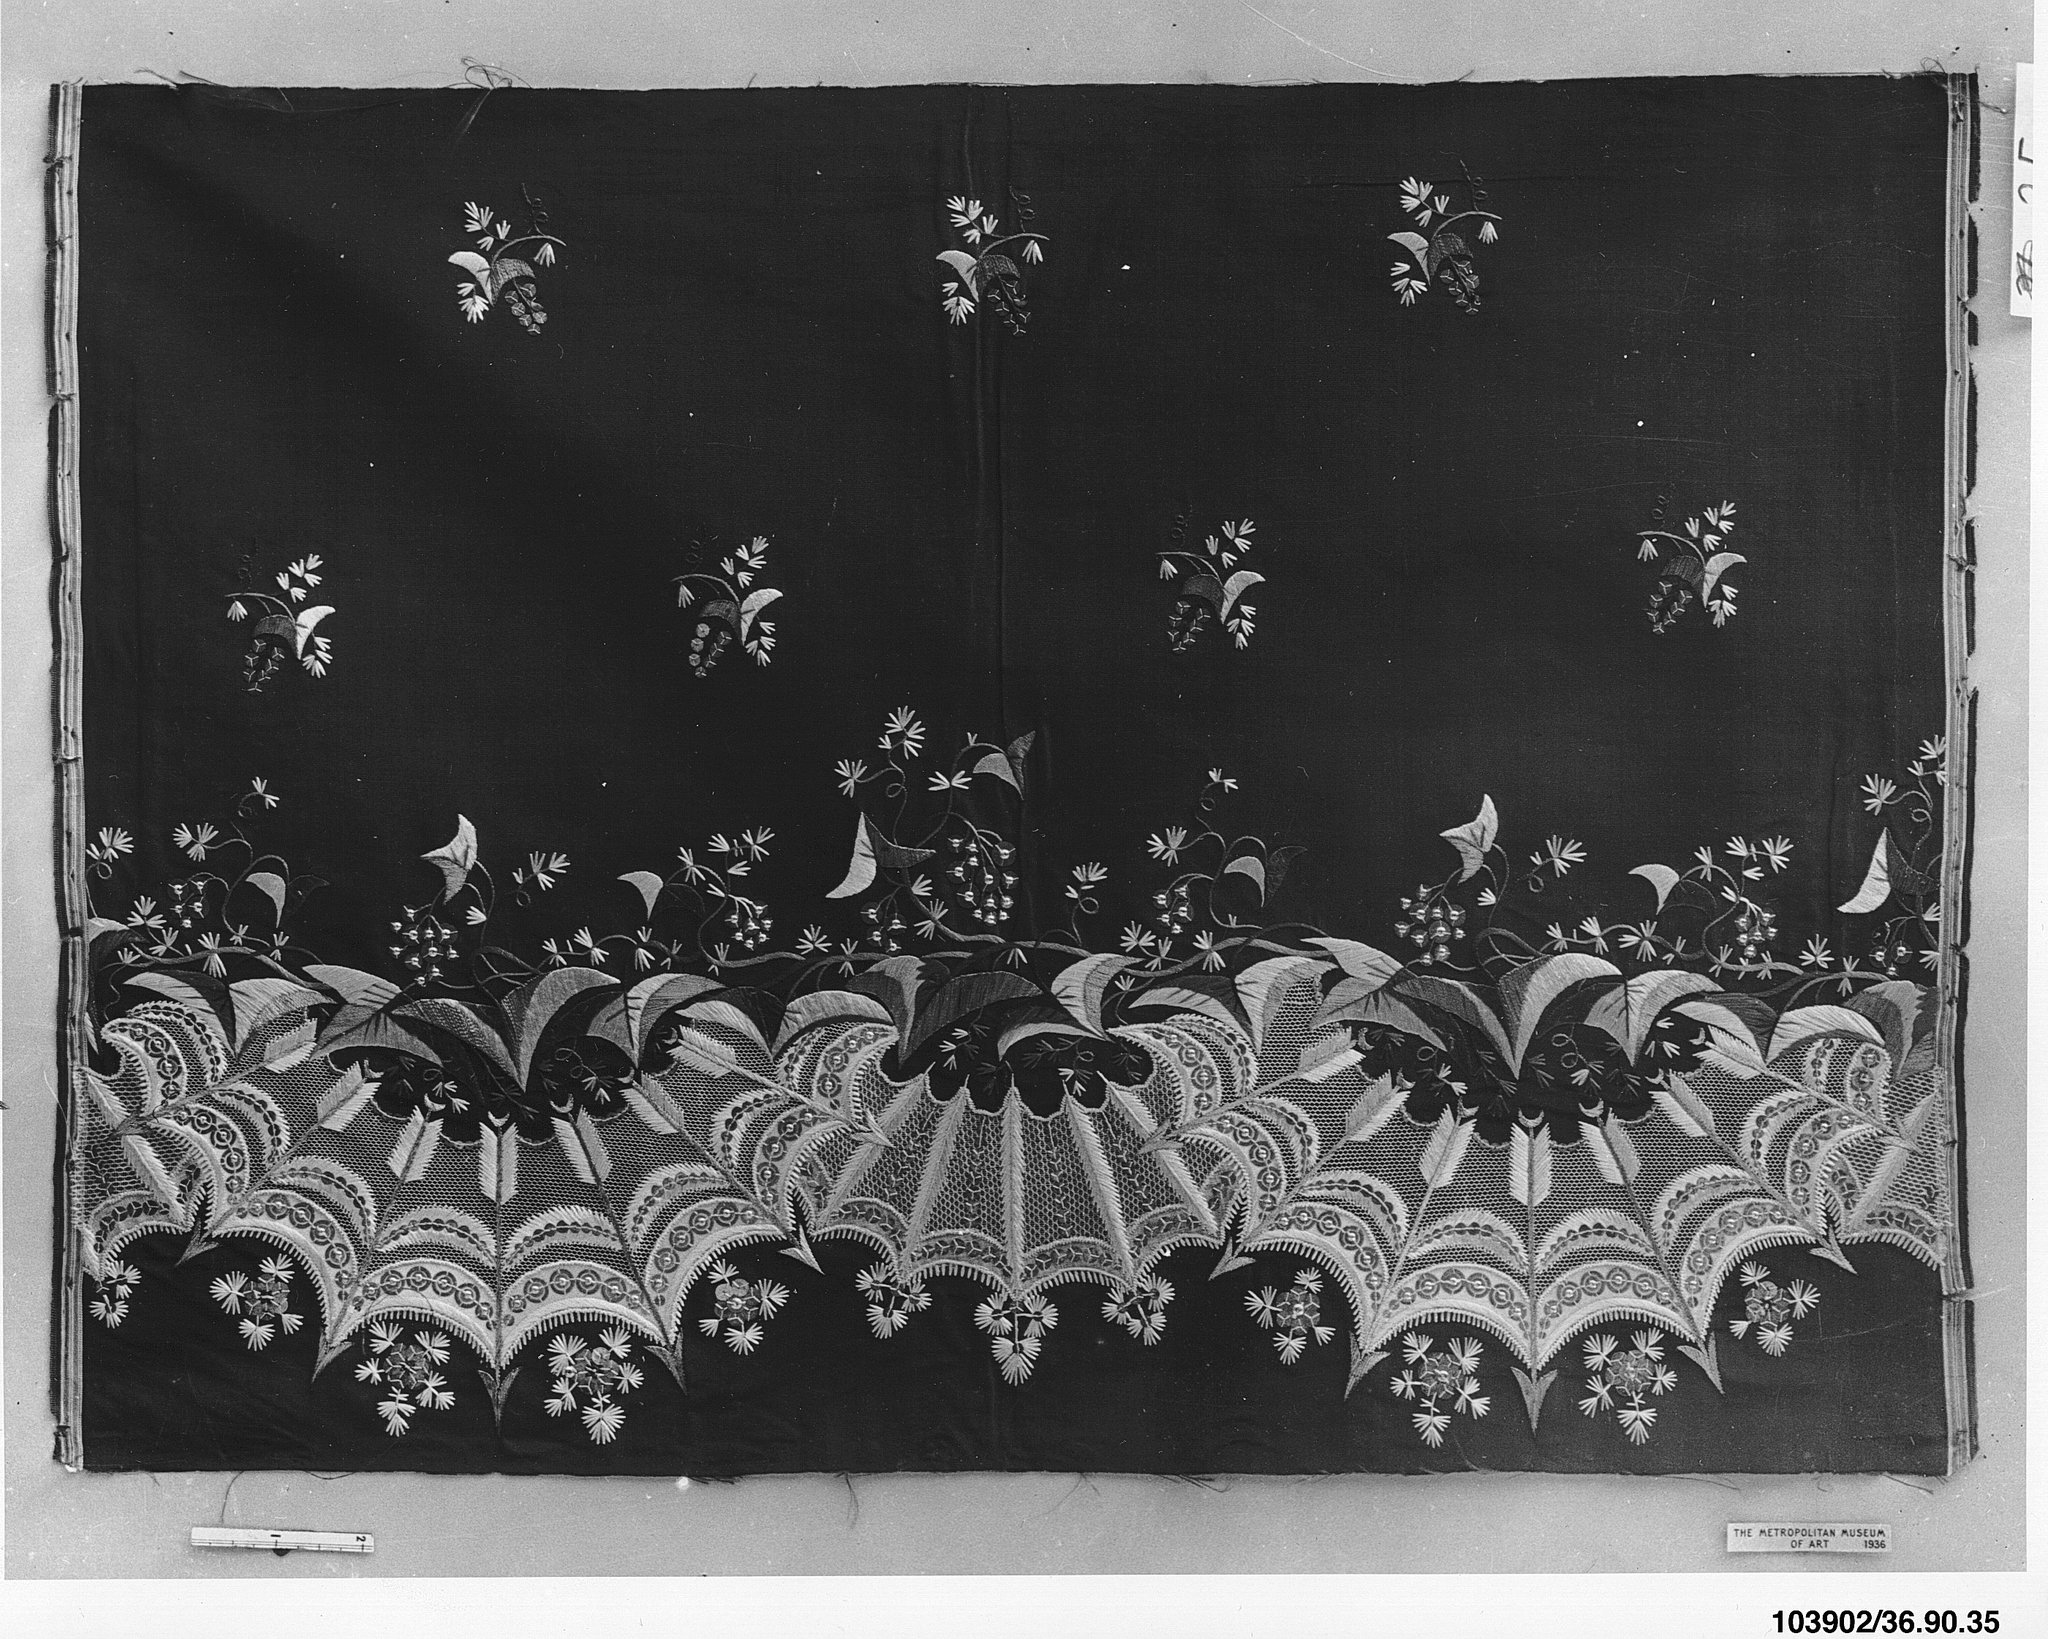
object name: border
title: Dress border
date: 1801-1833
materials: metal thread, silk